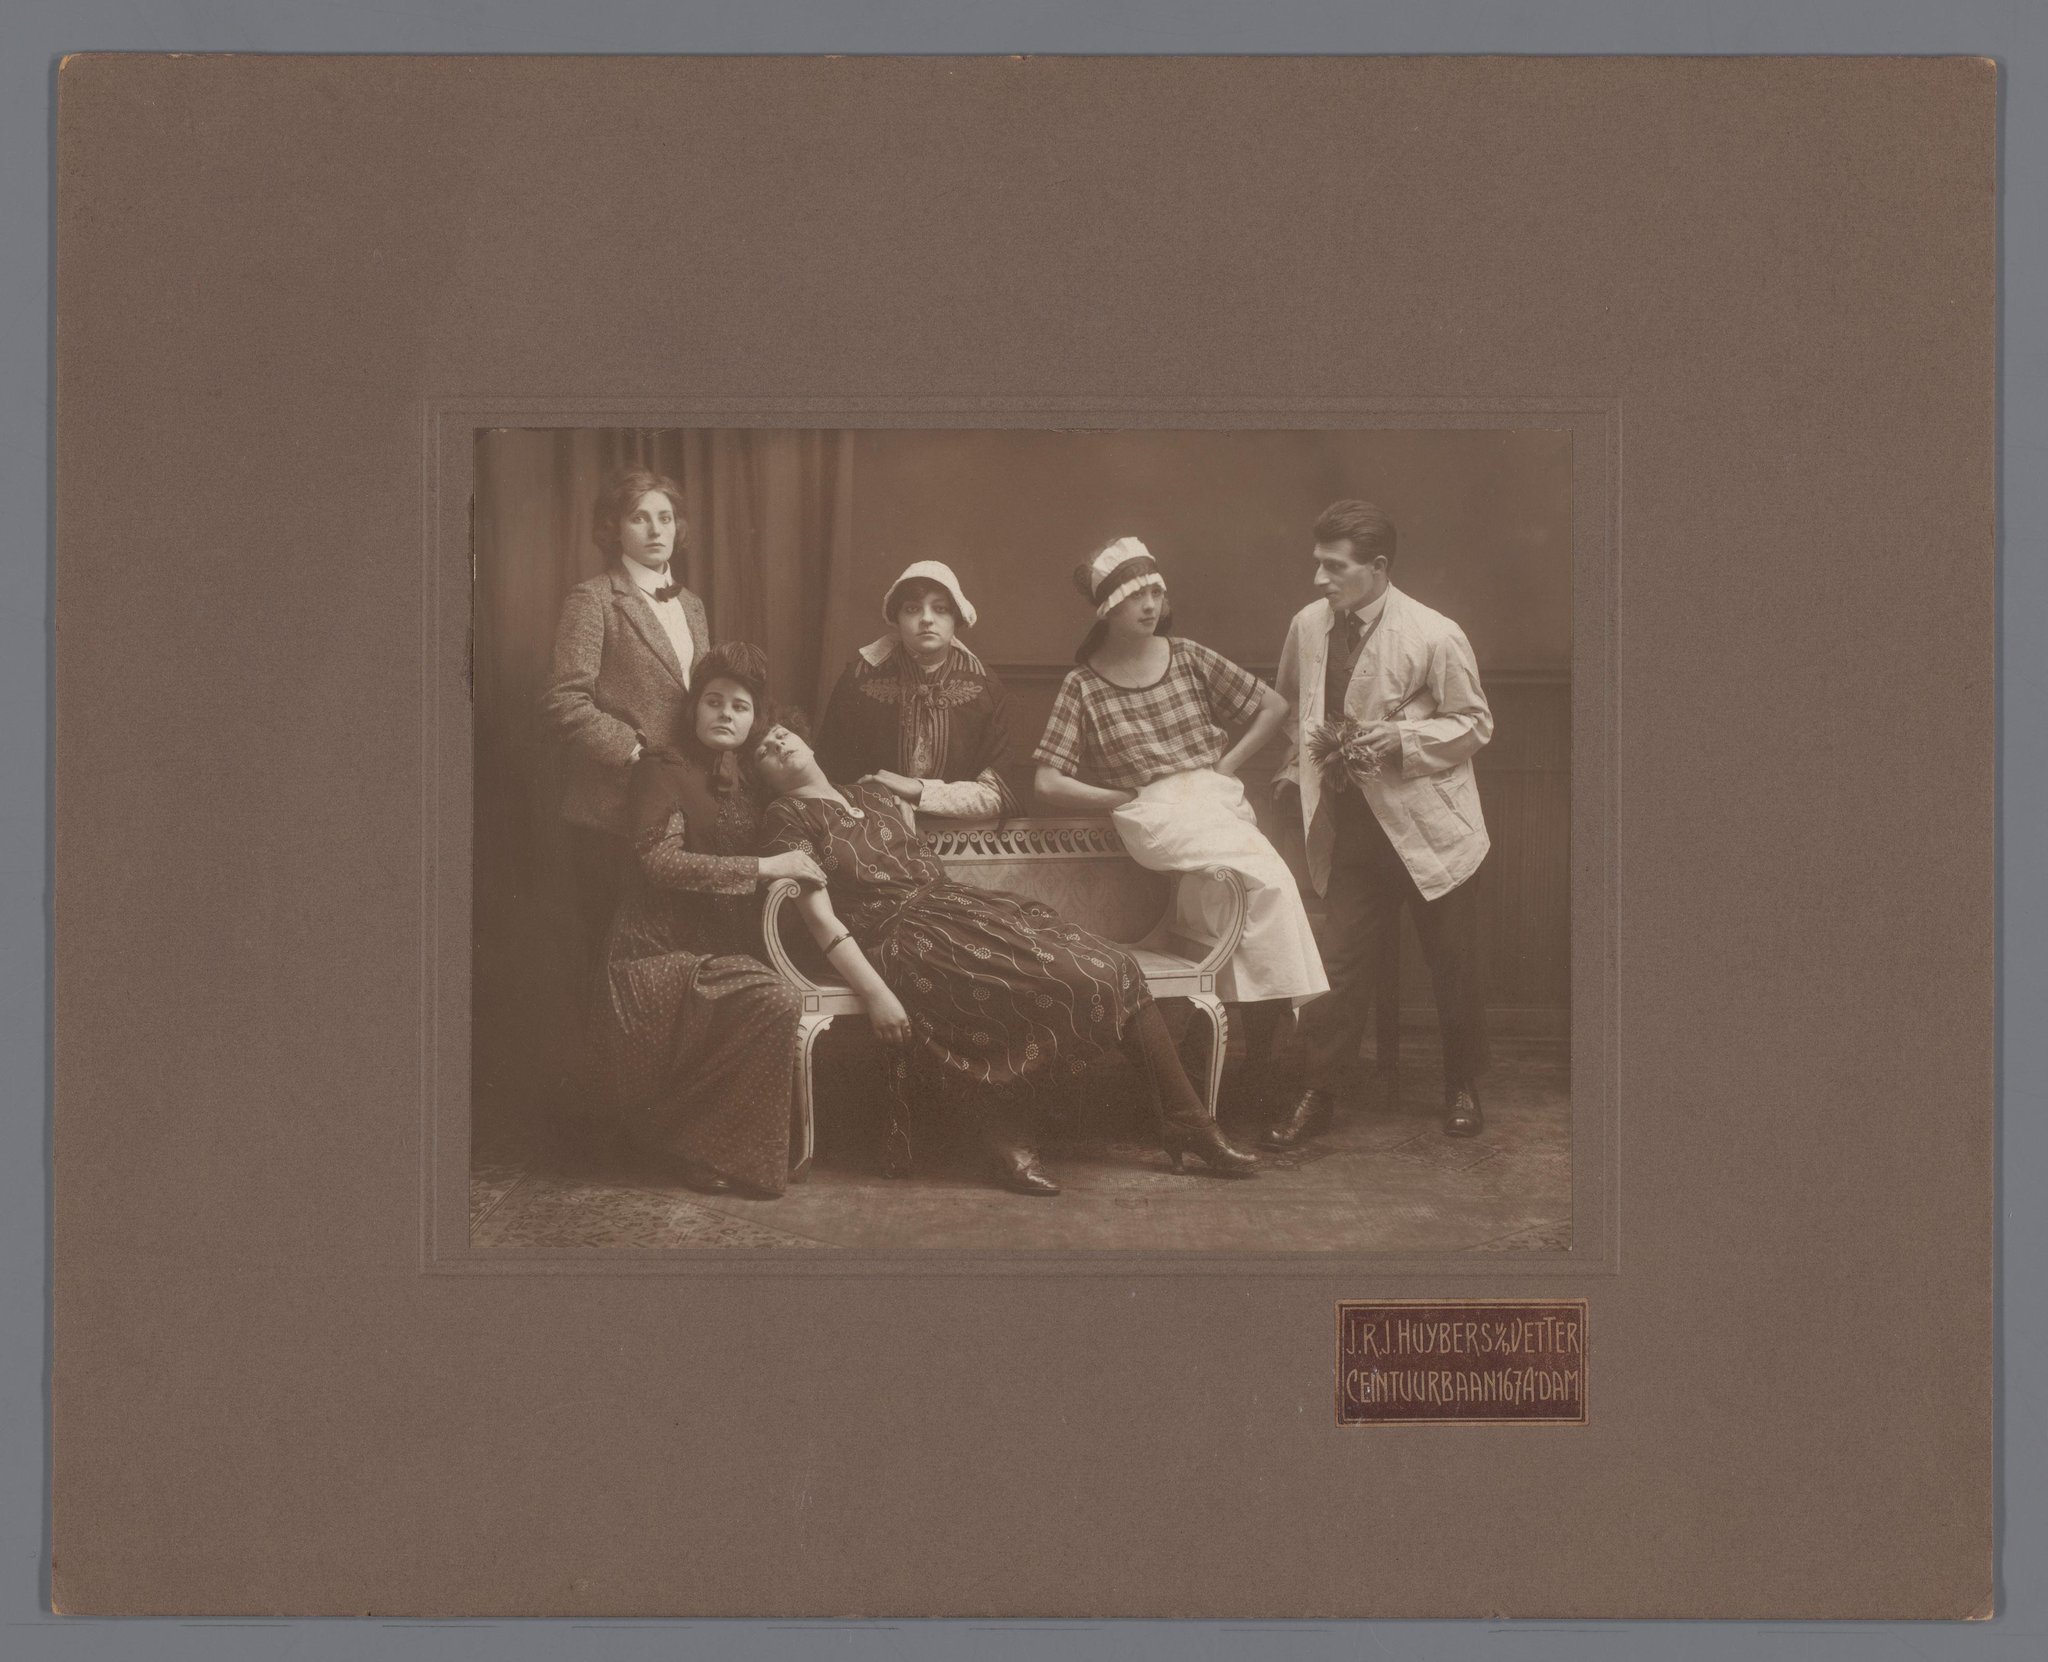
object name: photograph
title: Groepsportret in studio; zes mannen en vrouwen zittend, liggend en staand rond een bank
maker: j.r.j. huybers van het vetter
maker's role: fotograaf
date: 1900-1920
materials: photographic support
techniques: gelatin silver print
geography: amsterdam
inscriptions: label: ‘J.R.J.HUYBERS v/h VETTER//CEINTUURBAAN167A'DAM’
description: Groepsportret in studio. Zes mannen en vrouwen zittend, liggend en staand rond een bank. Een van de vrouwen ligt alsof ze flauw viel achterover op de bank.